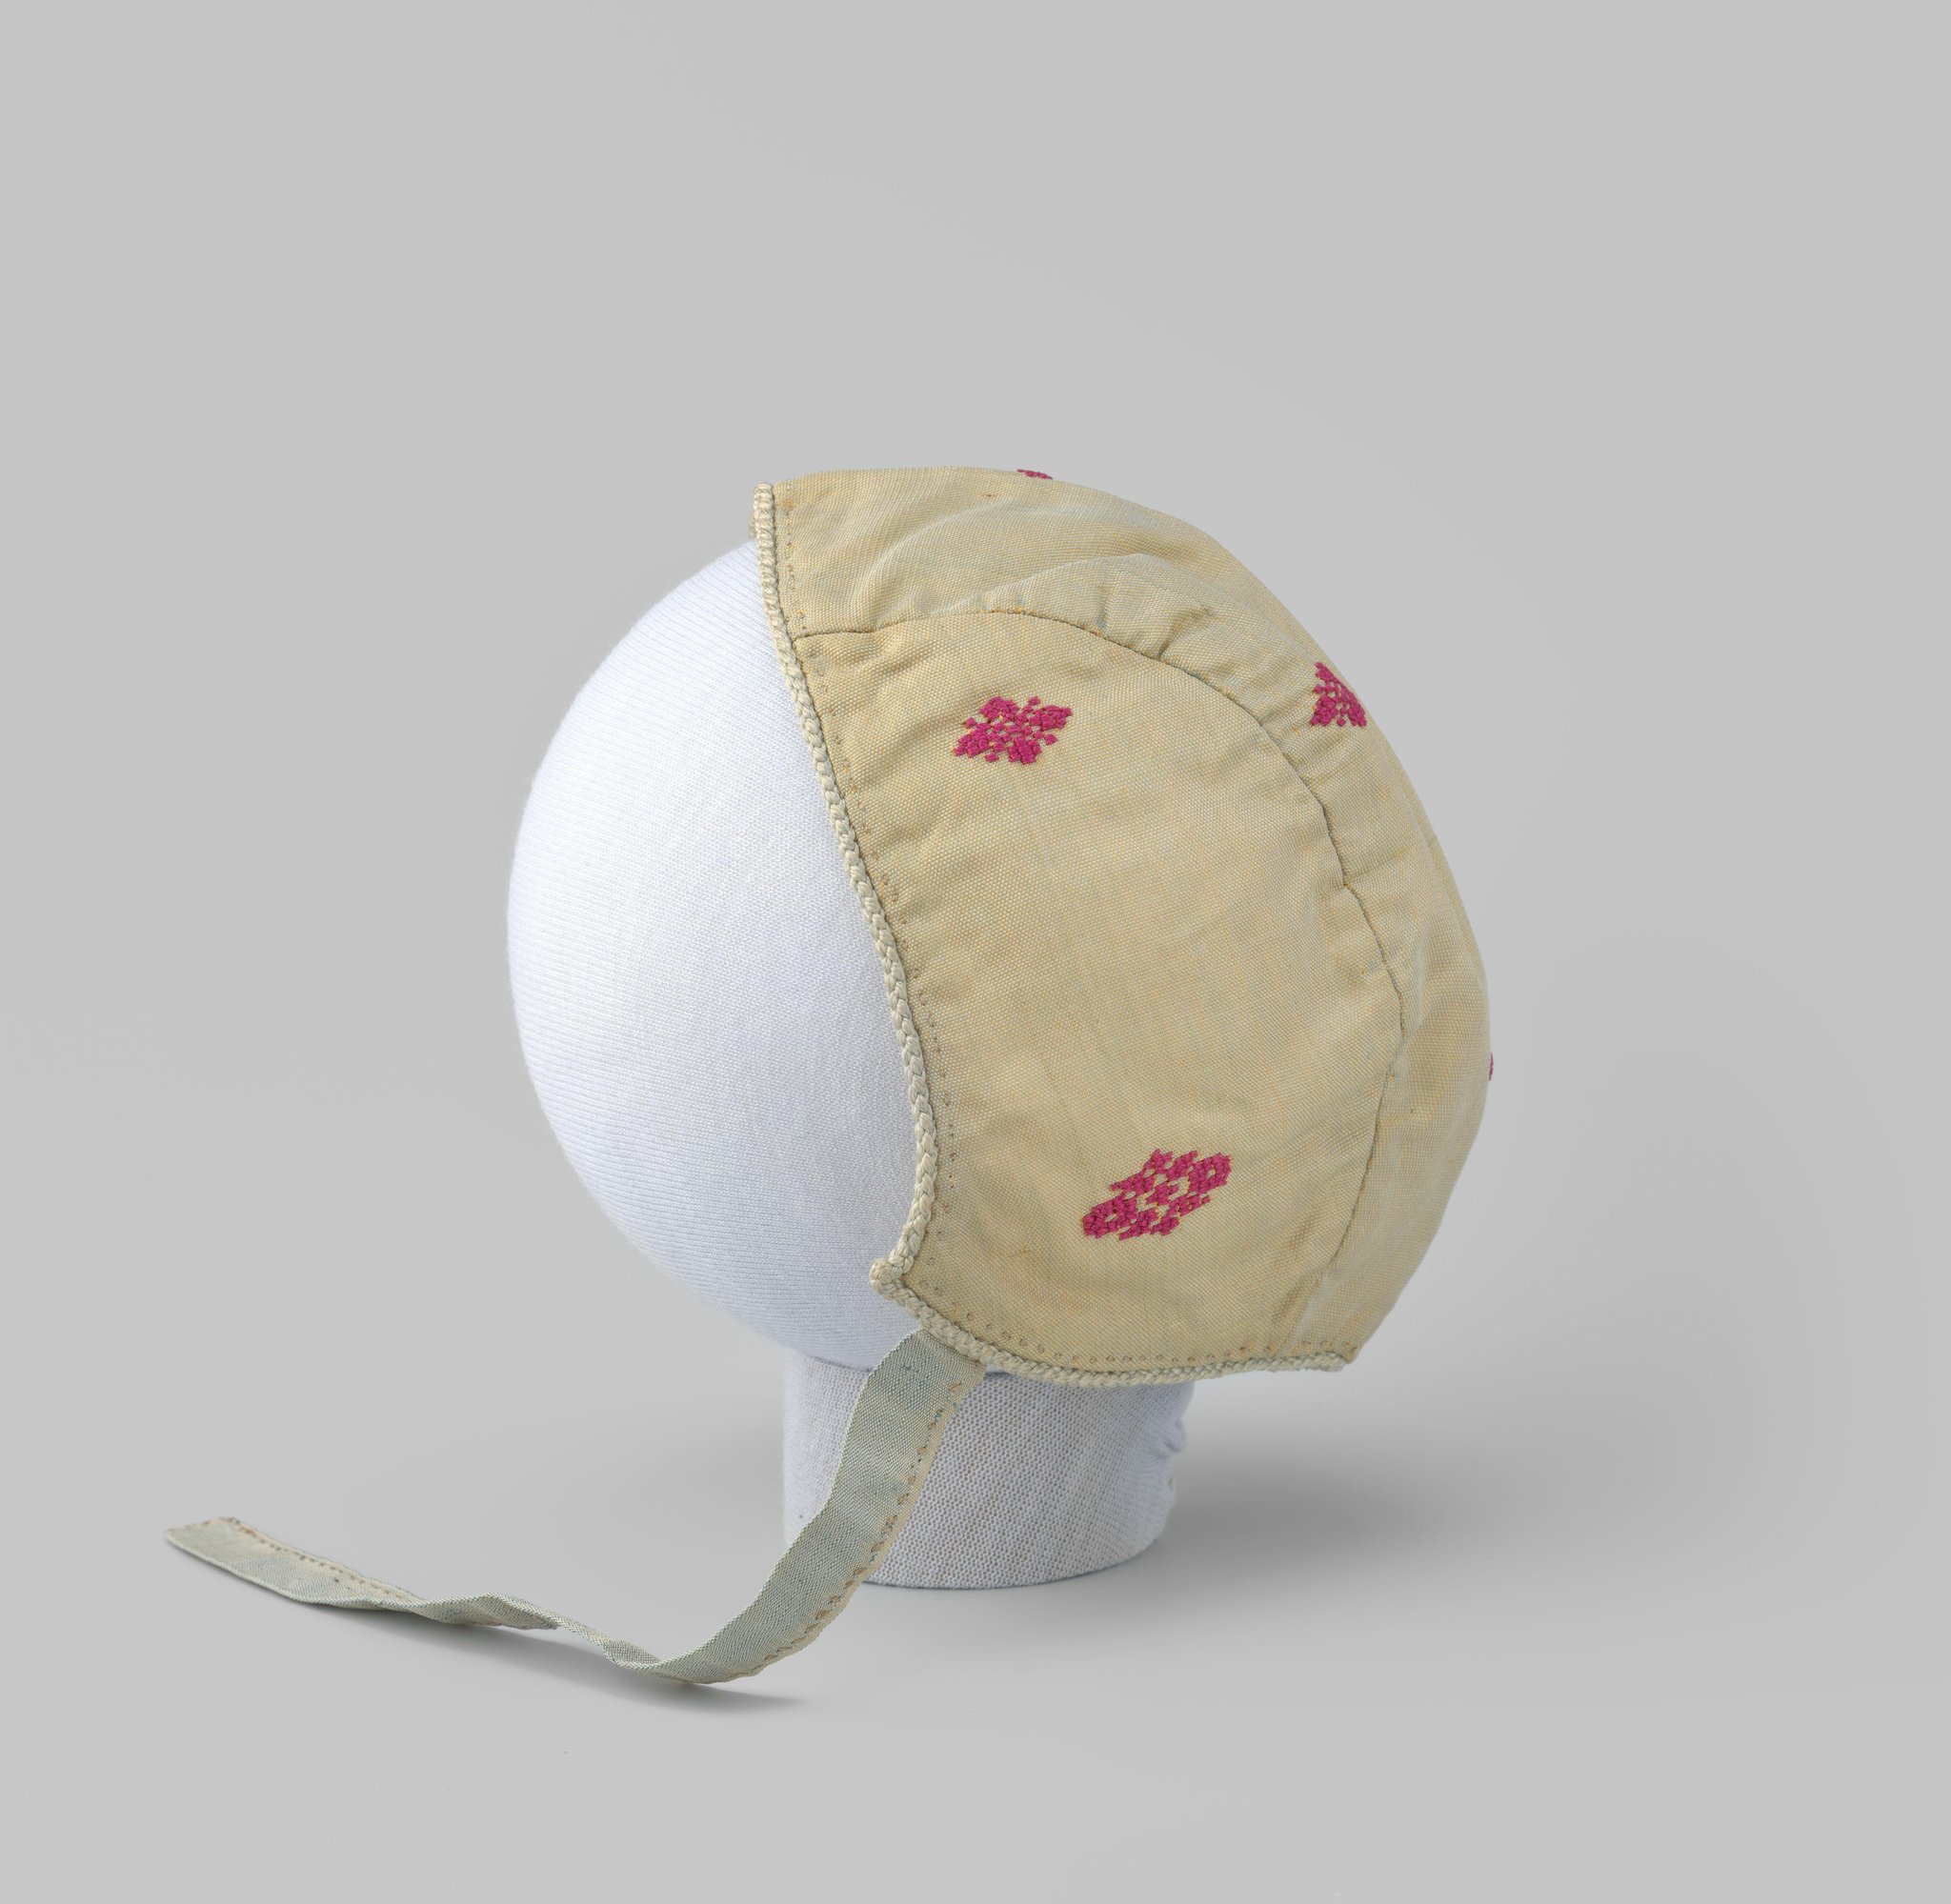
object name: cap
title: Kindermuts van fletsgele changeantzijde met rood bloempje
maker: Anonymous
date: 1700-1800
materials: silk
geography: netherlands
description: Kindermuts van fletsgele changeantzijde met rood bloempje. Model met drie passen. Randversiering rondom en één lintje aan de linkerpunt.